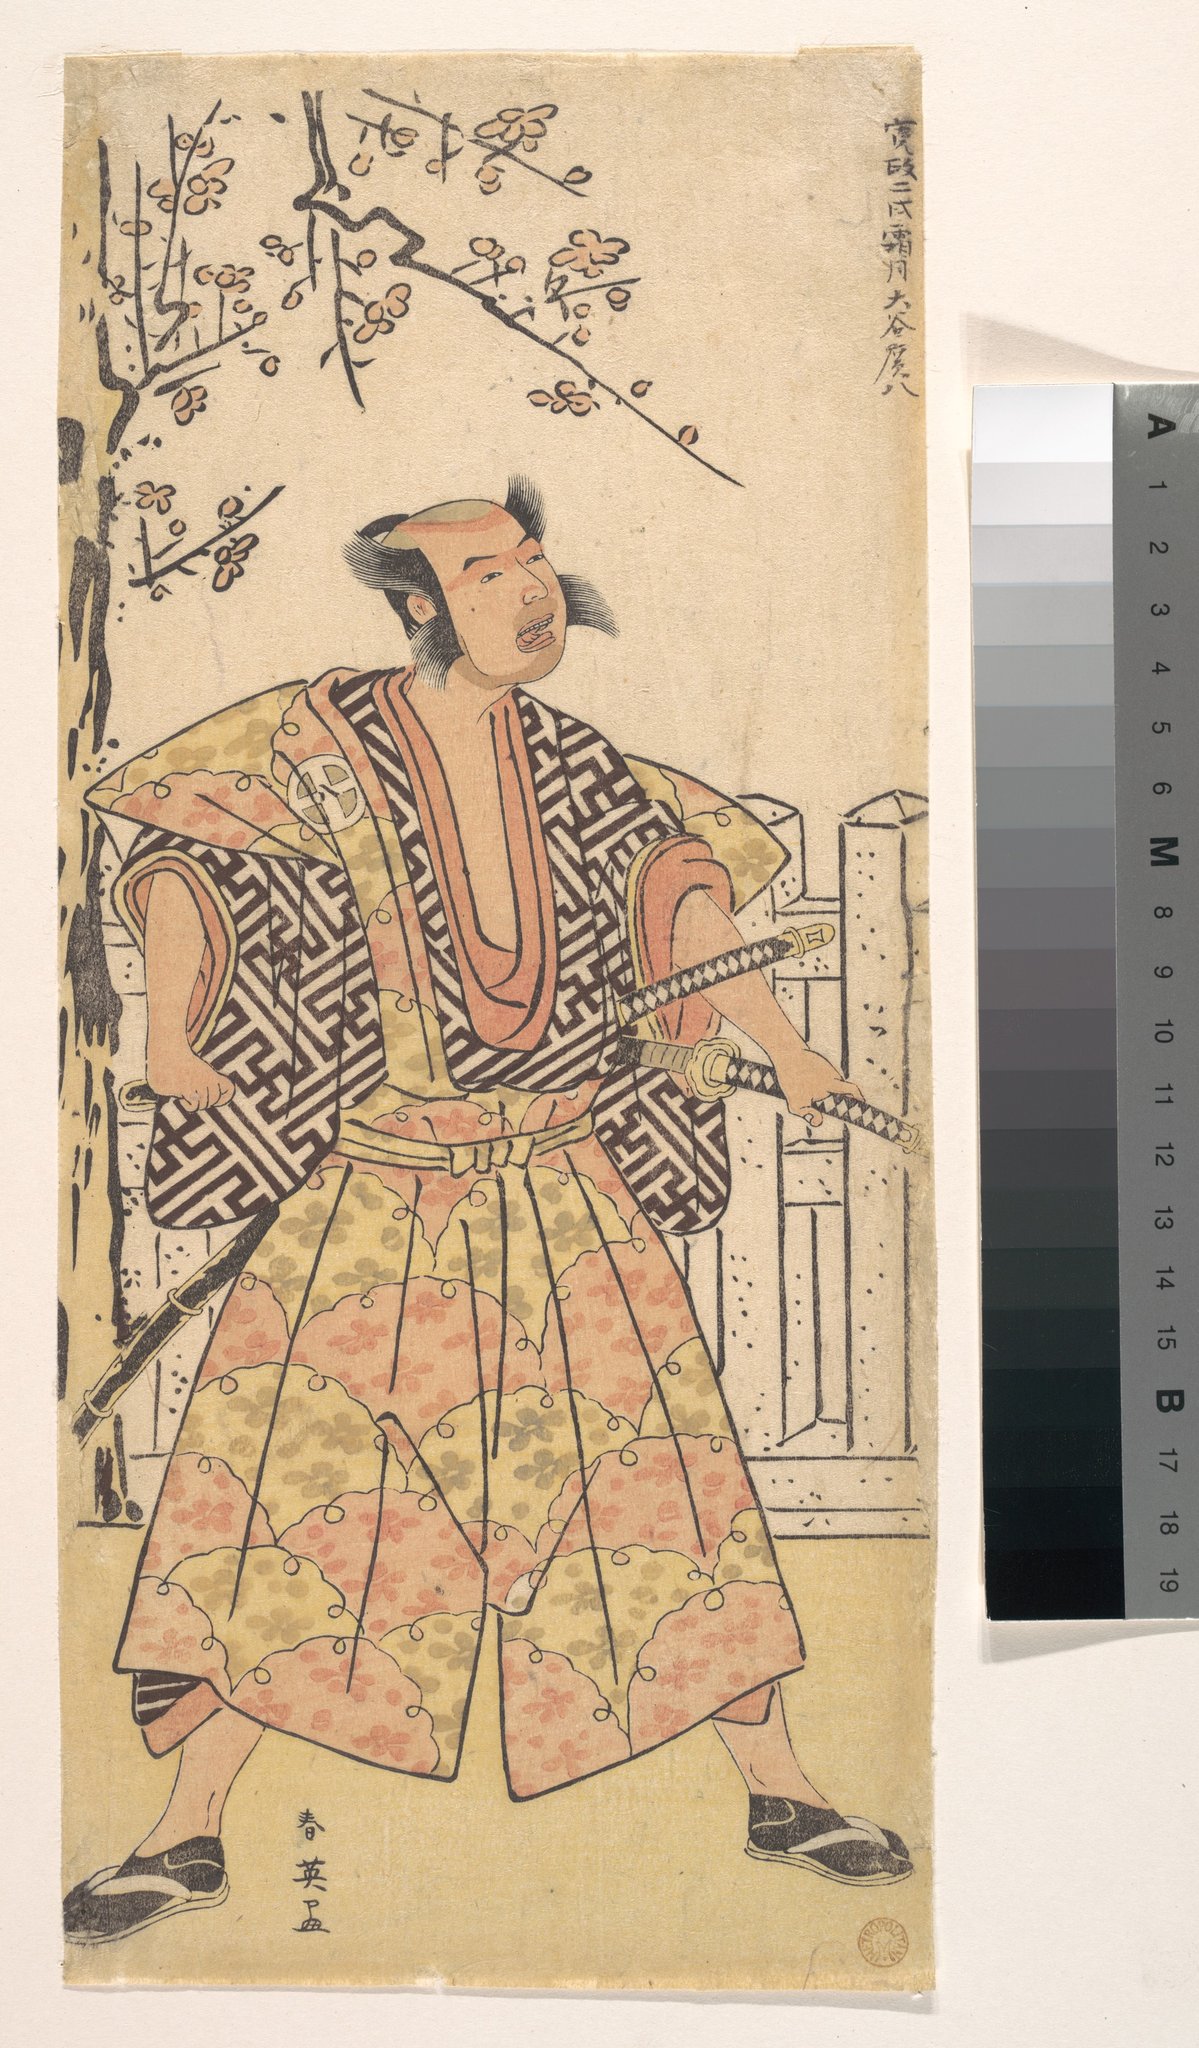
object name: print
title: Otani Hirohachi as a Samurai Dressed in a Gaudy Kamishimo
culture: japanese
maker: katsukawa shun'ei 勝川春英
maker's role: artist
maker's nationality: japanese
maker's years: 1762-1819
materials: ink, paper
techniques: woodblock print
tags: men,actors